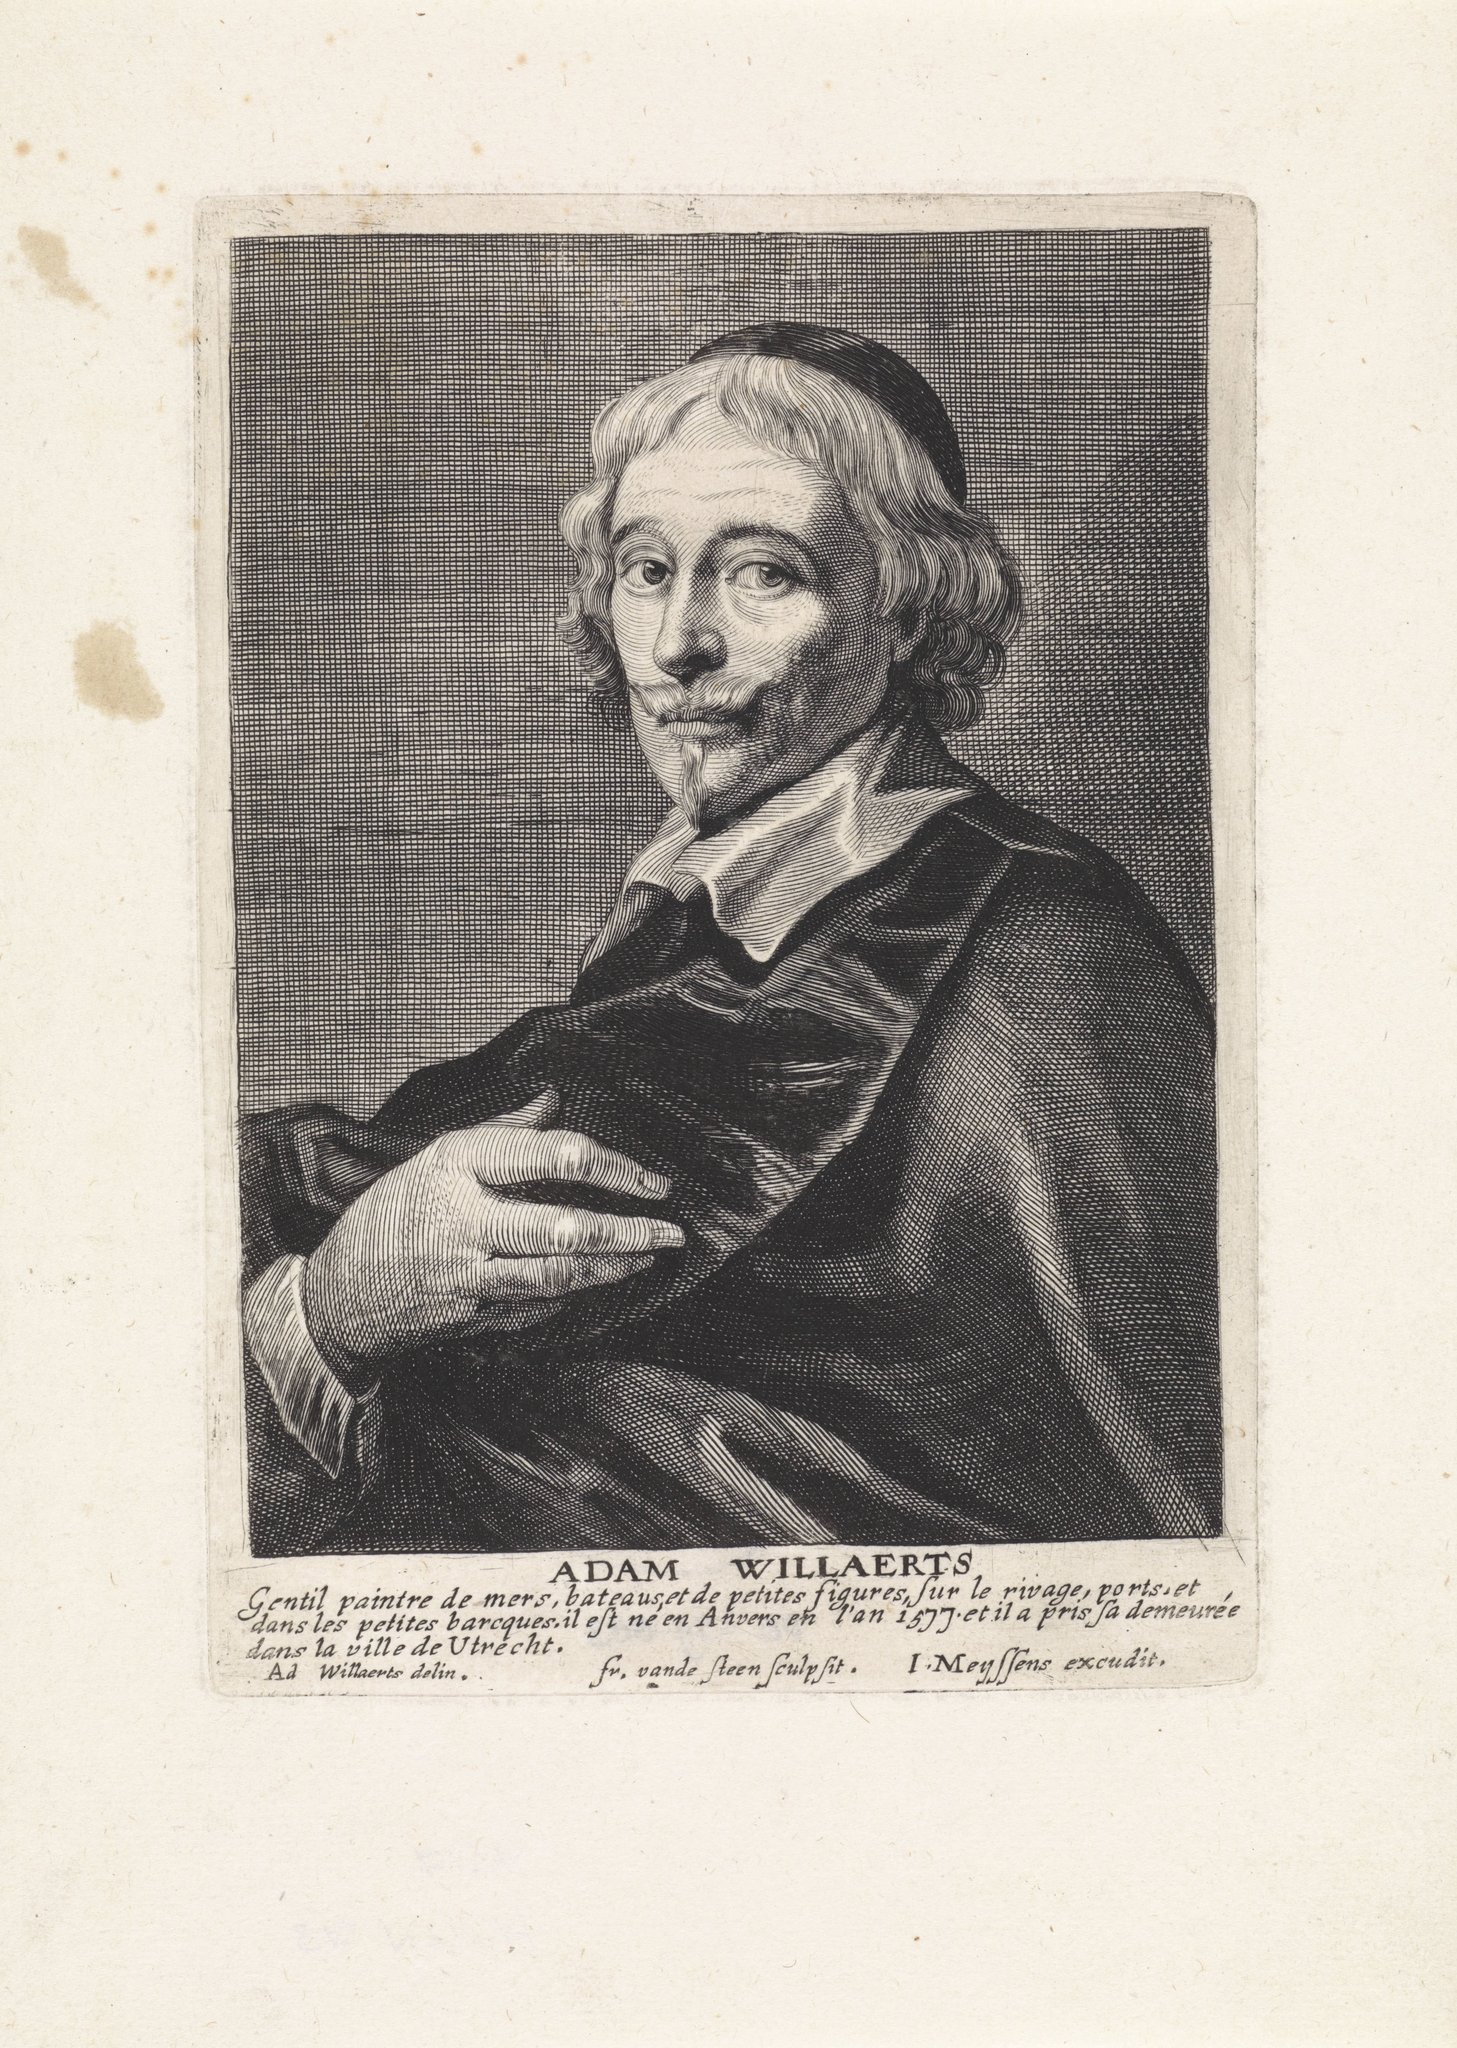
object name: print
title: Portret van Adam Willaerts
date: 1649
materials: paper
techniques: engraving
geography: antwerp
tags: london, utrecht, painter, adam willaerts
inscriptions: collector's mark: Lugt 2228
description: Prent uit de serie: Image de divers hommes desprit sublime qui par leur art et science devront vivre eternellement et des quels la lovange et renommée faict estonner le monde, A Anvers mis en lumiere par Iean Meyssens peinctre et vendeur de lart au Cammestraet l'an .M.DC.XLIX. Antwerpen: Joannes Meyssens, 1649.